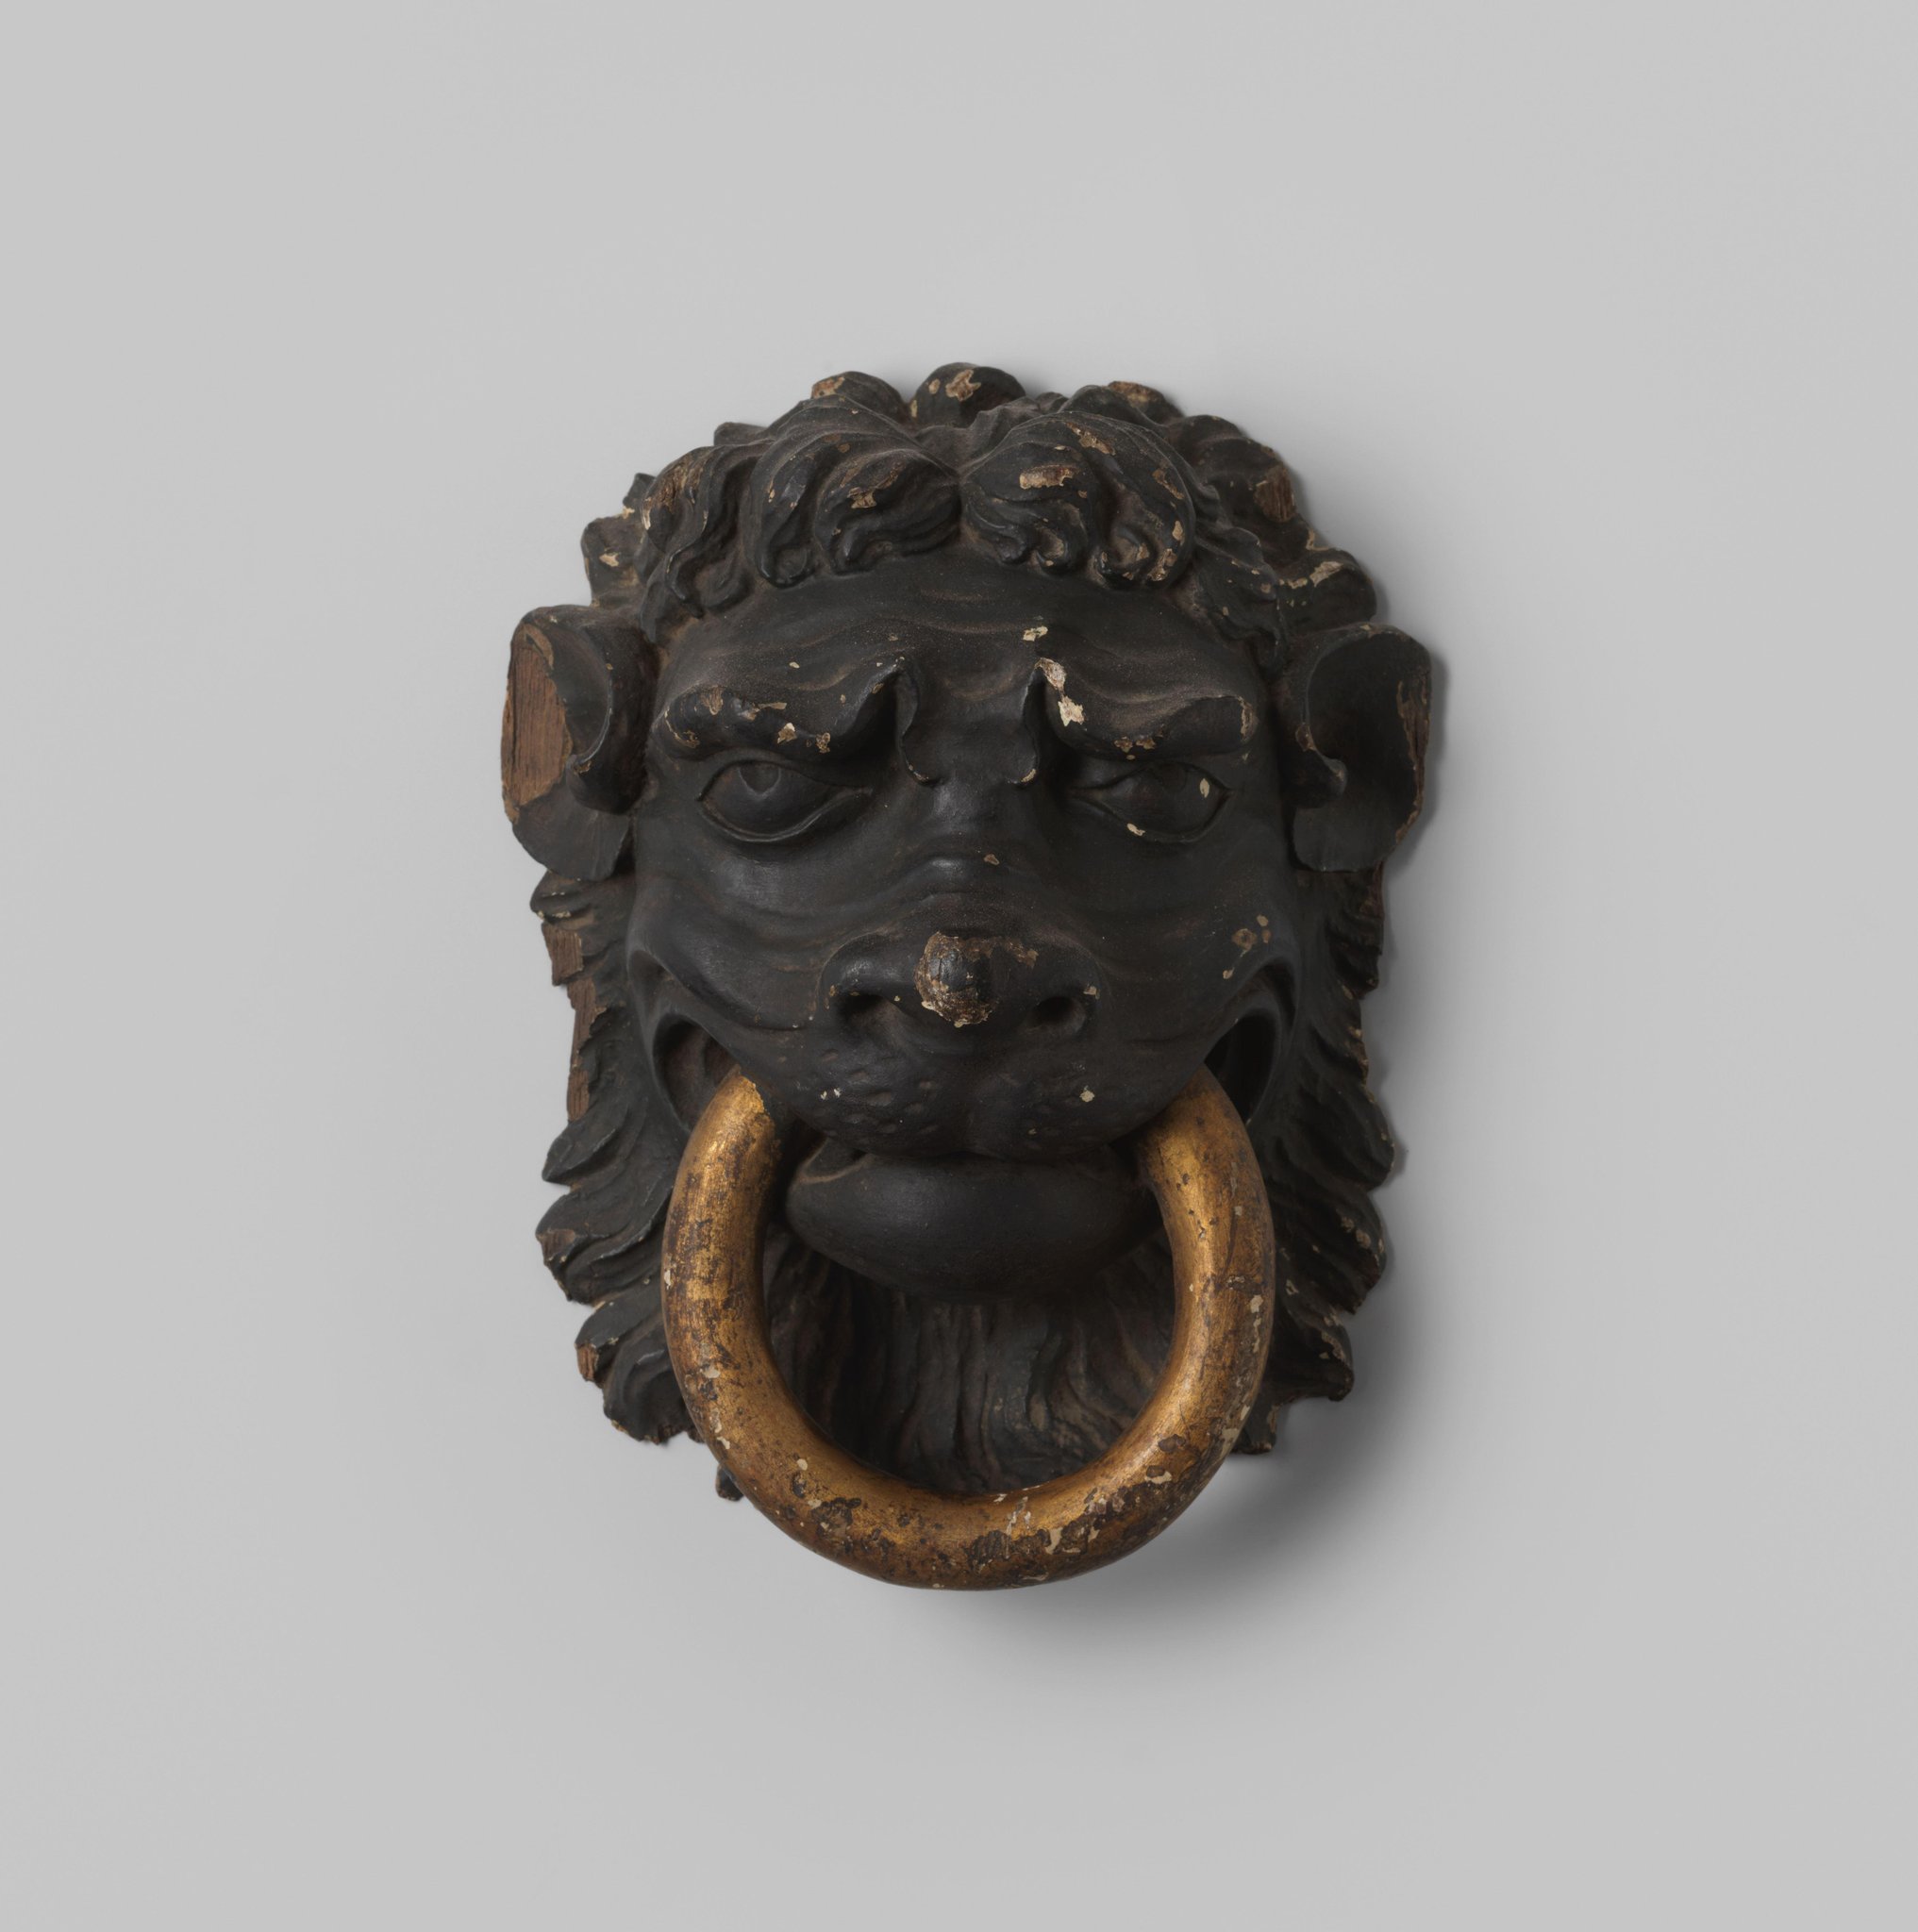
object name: door knocker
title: Deurklopper in de vorm van een leeuwenkop van hout met een vergulde ring in zijn bek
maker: Anonymous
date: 1600-1699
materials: wood, paint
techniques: gilding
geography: netherlands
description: Deurklopper in de vorm van een leeuwenkop van hout met een vergulde ring in zijn bek.